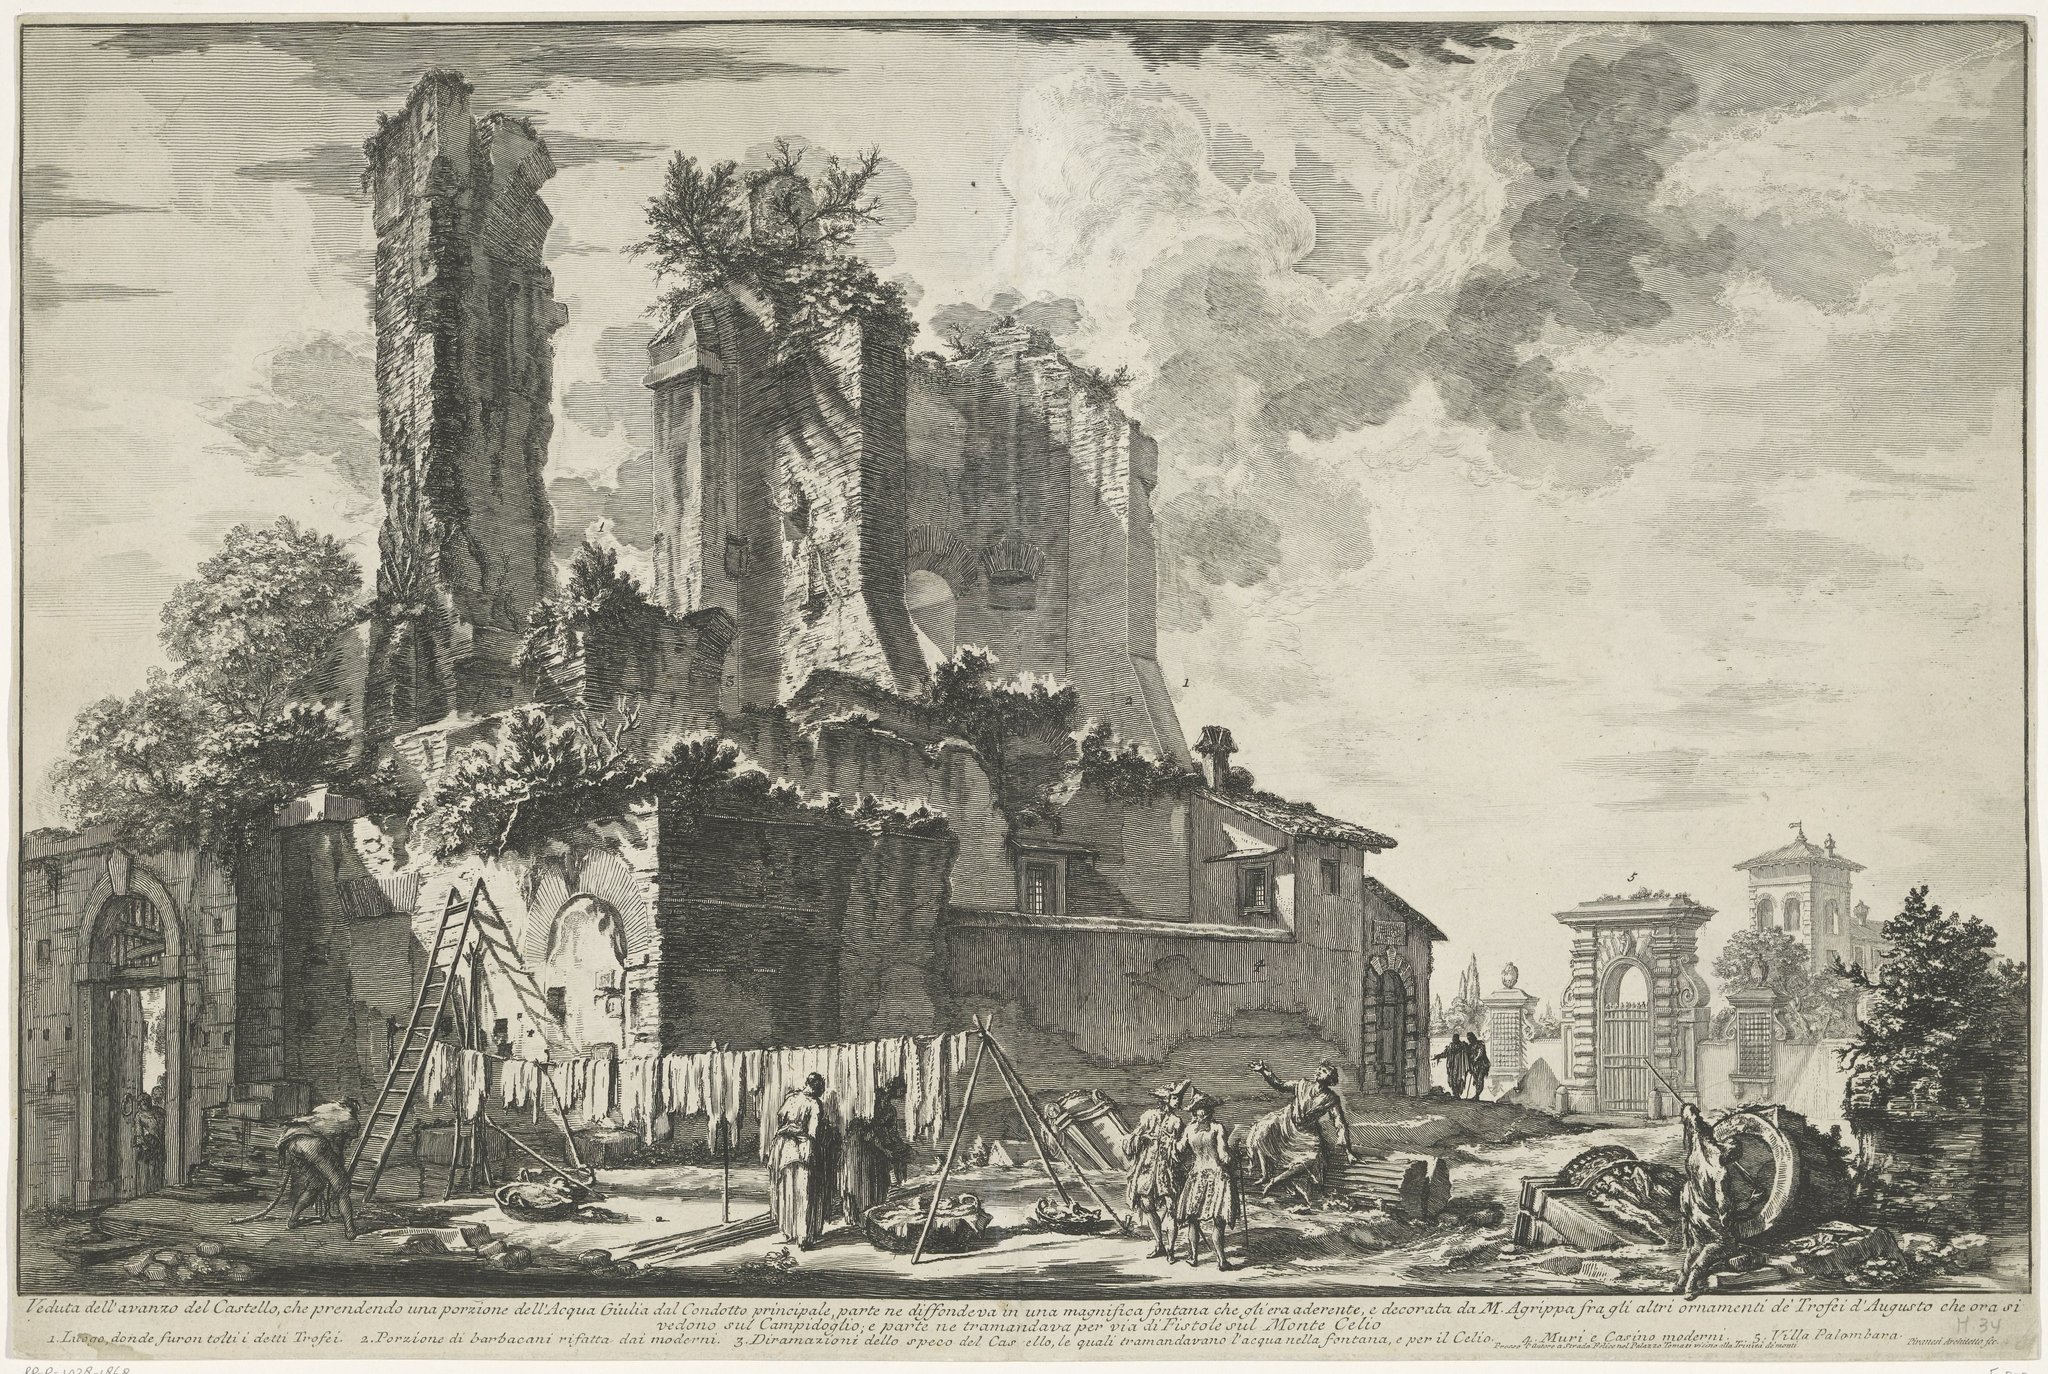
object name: print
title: Gezichten op Rome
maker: giovanni battista piranesi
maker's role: designer, draughtsman, print maker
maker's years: 1720-1778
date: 1748-1778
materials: paper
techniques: etching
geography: rome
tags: city-view, and landscape with man-made constructions, landscape with bridge, viaduct or aqueduct, landscape with ruins, aqueduct (~ water supply), rome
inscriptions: collector's mark: Lugt 789a, collector's mark: Lugt 2228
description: Deze prent maakt deel uit van de serie 'Vedute di Roma'. Piranesi werkte aan deze 135 platen tellende serie tussen 1748 en zijn dood in 1778. Francesco Piranesi voegde later nog twee prenten toe aan de reeks van zijn vader.